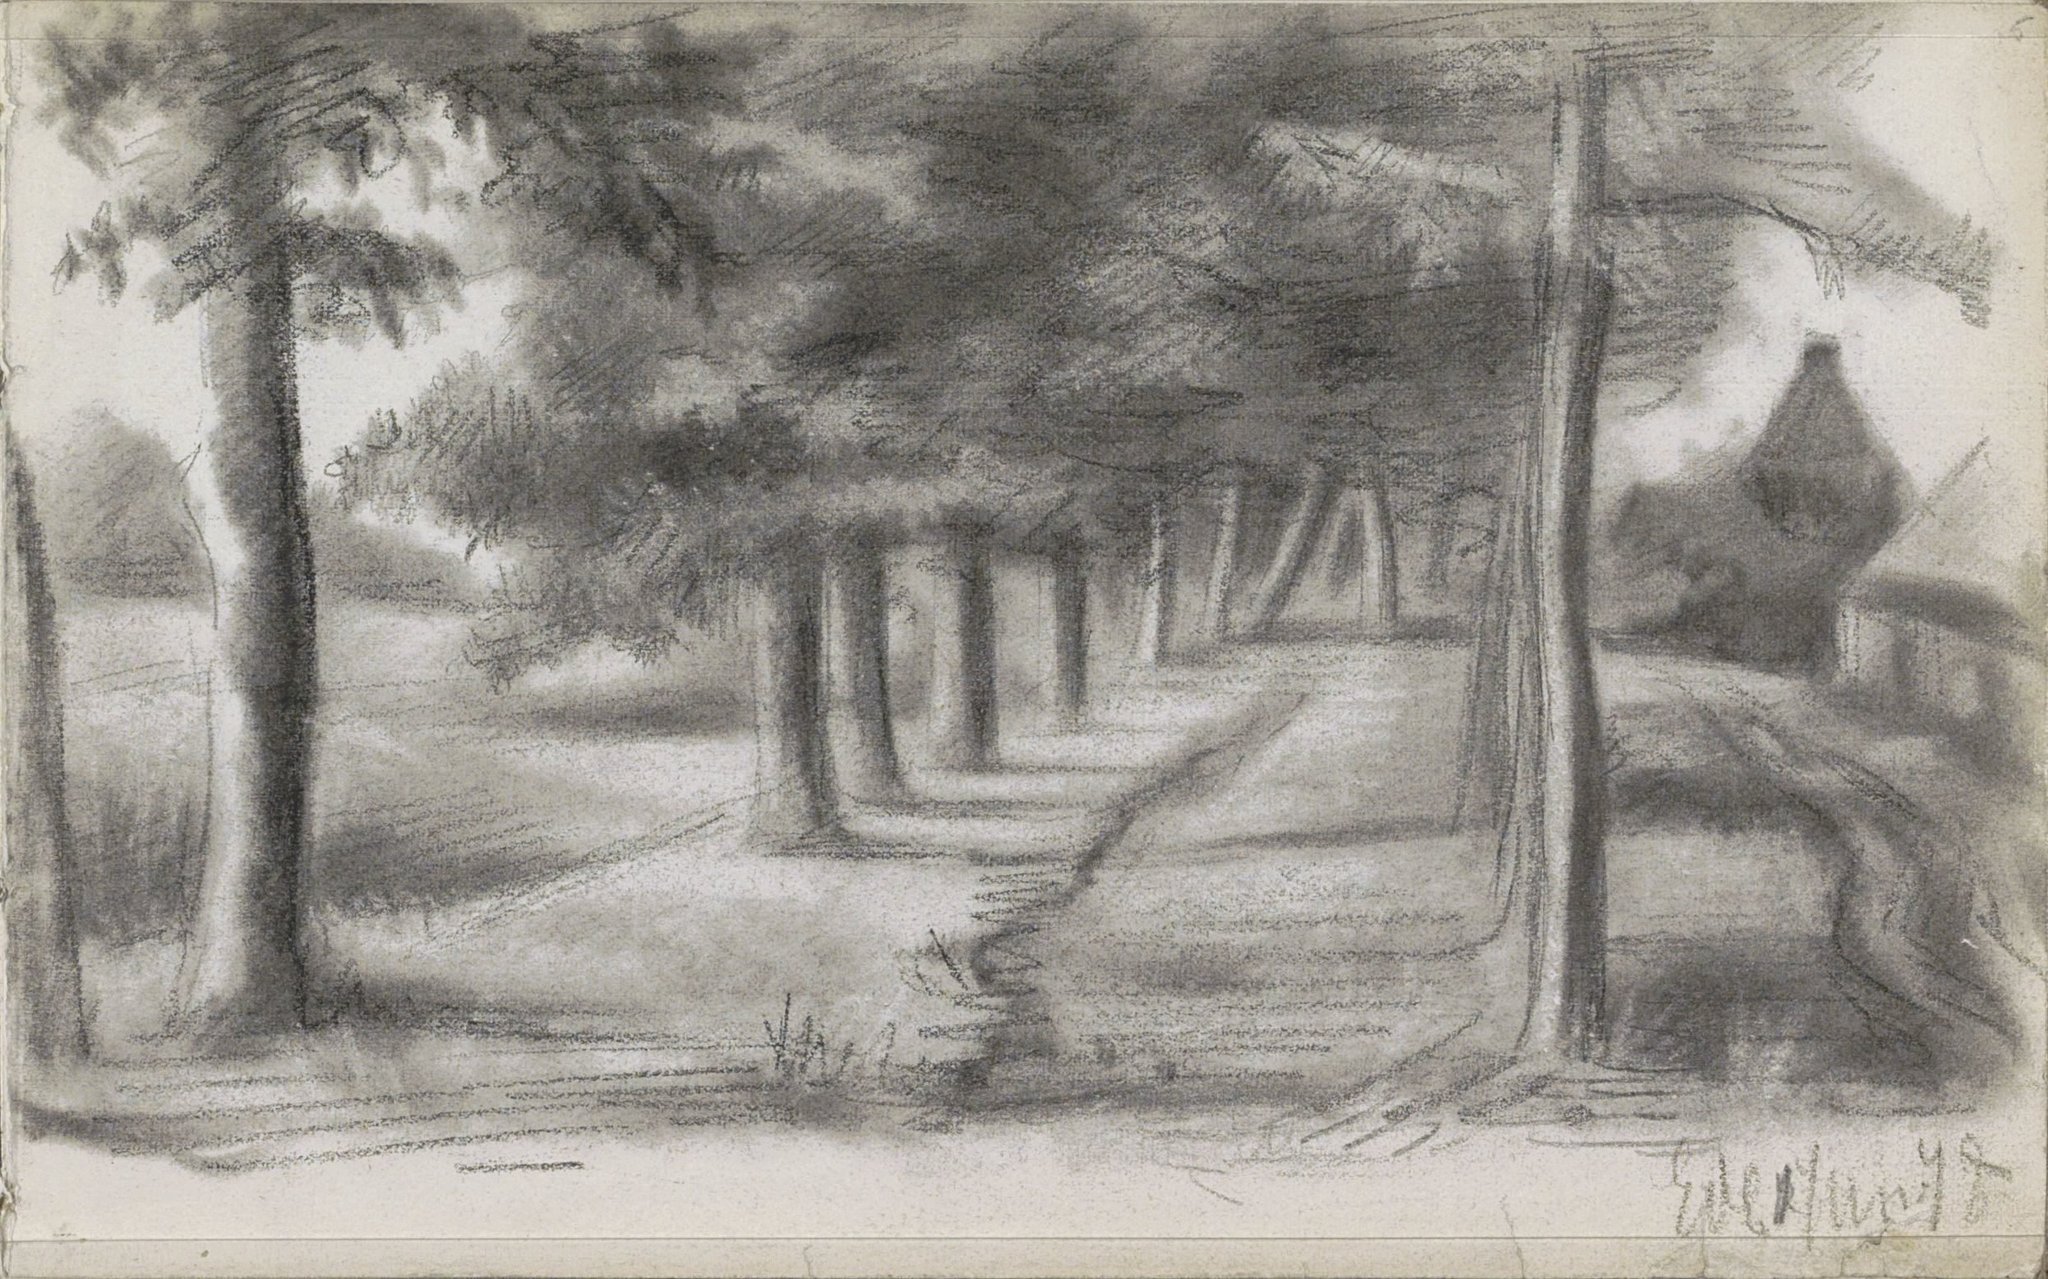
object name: sketchbook leaf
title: Gezicht op een laan in Ede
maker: willem witsen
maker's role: draughtsman, painter, print maker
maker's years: 1860-1923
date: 1806-1878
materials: chalk, paper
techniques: stumping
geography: ede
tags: rural housing, e.g. country-house, villa, cottage, forest path or lane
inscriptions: date: ‘Juni 78’, annotation: ‘Ede’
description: Rechts bebouwing. Pagina 5 uit een schetsboek met 23 bladen.